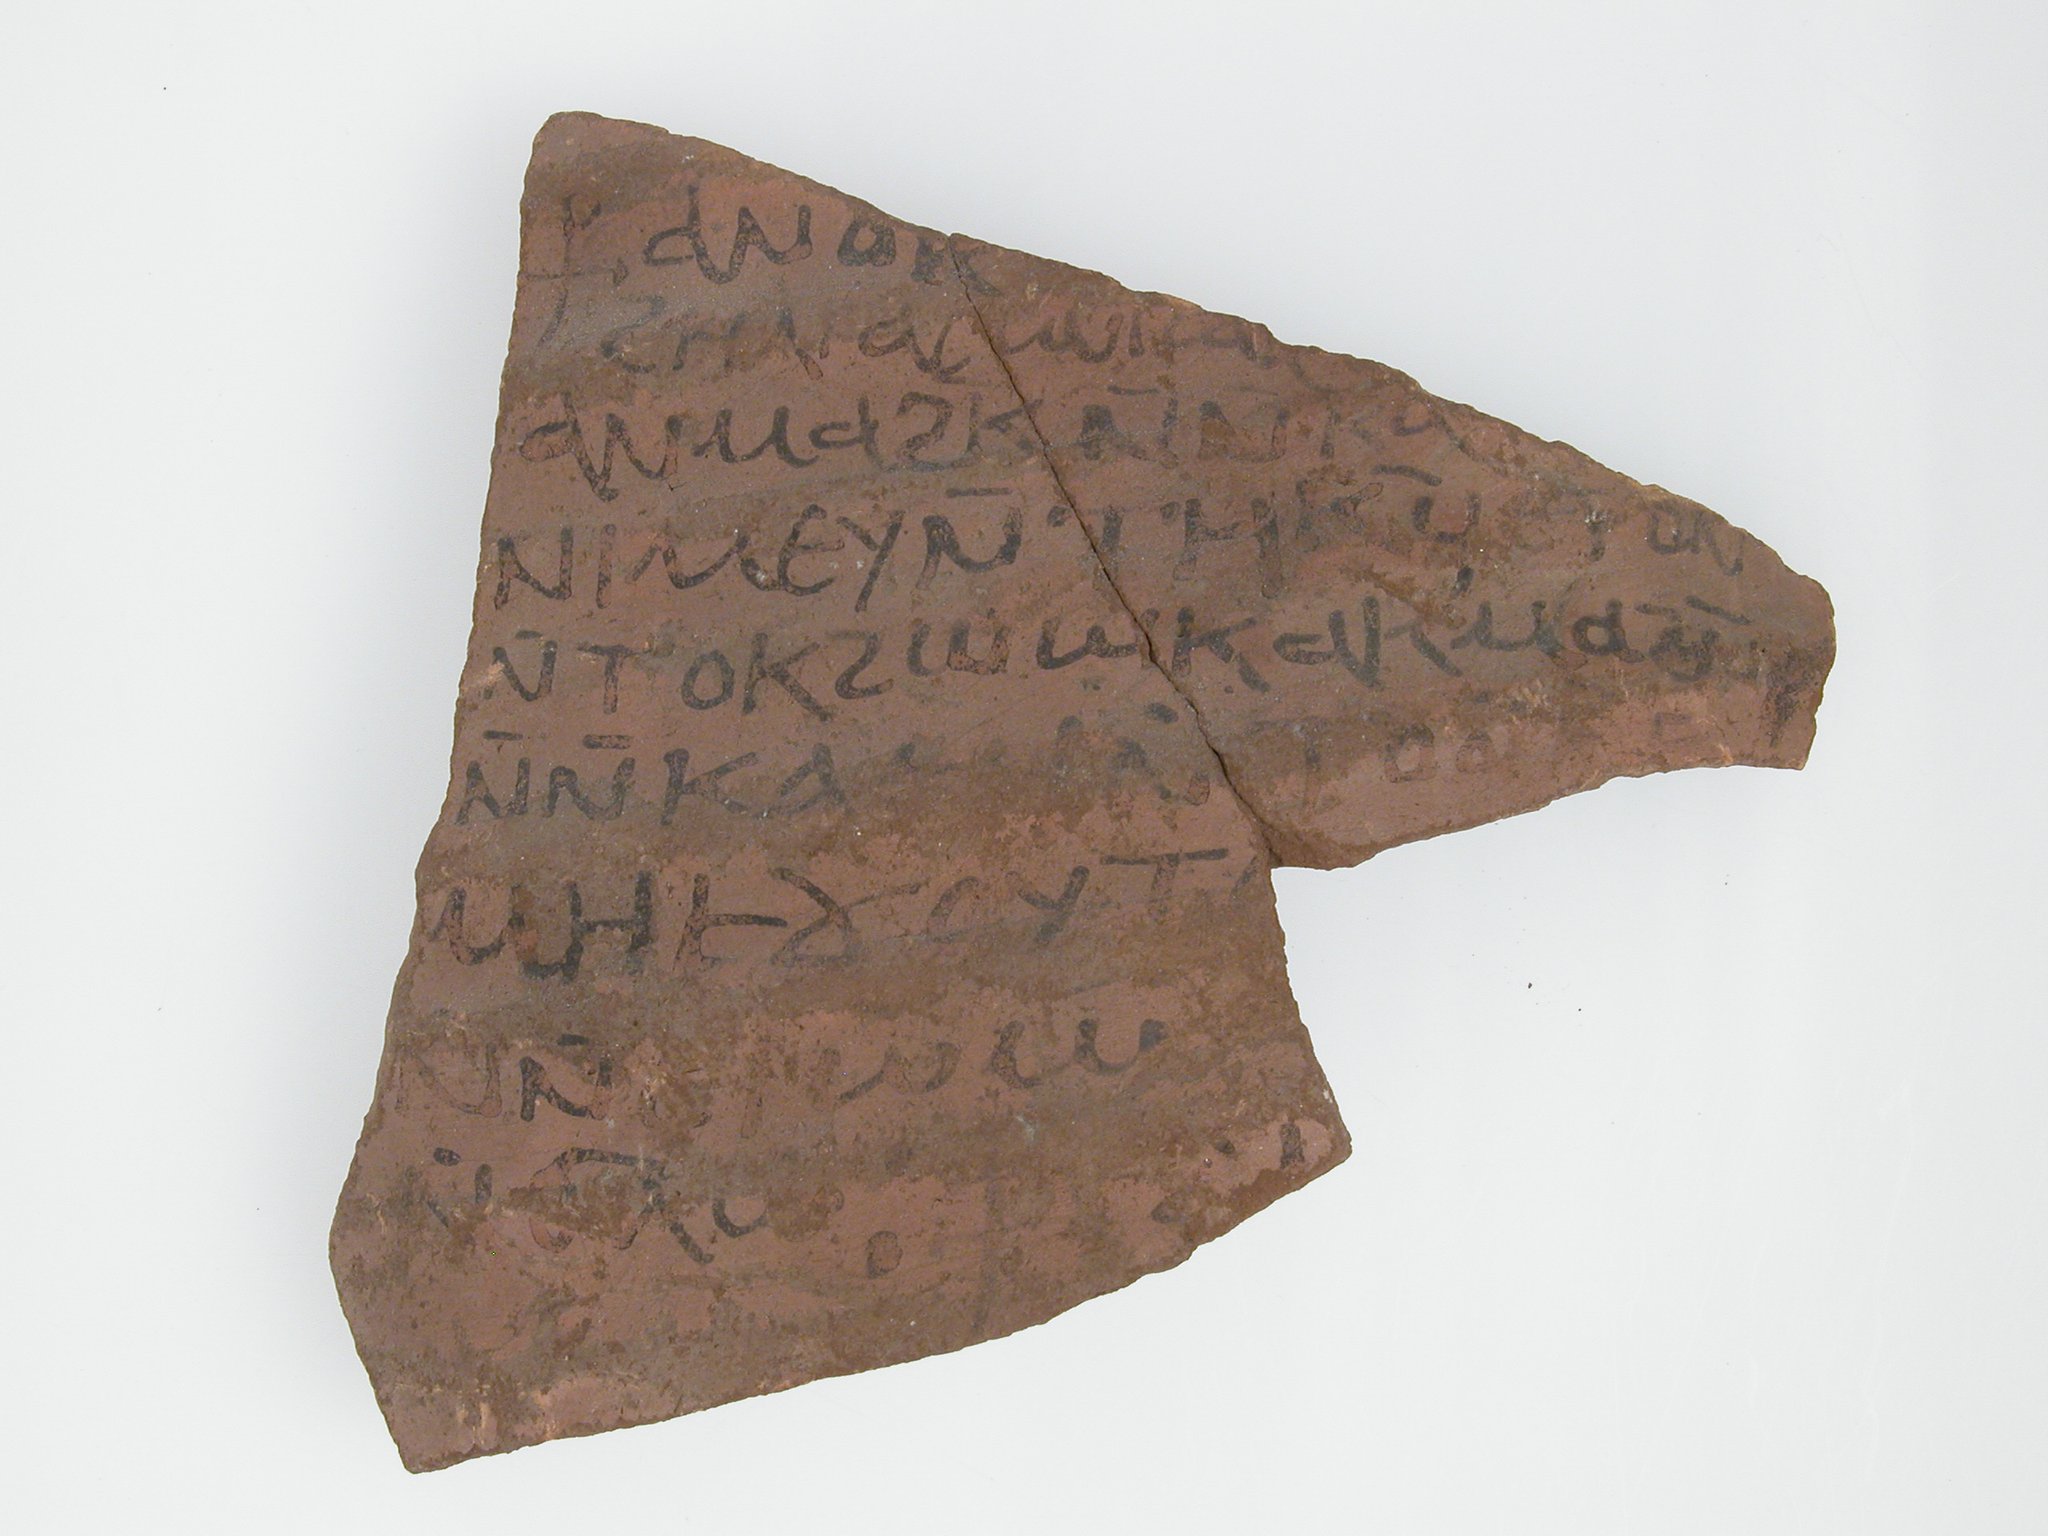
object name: ostrakon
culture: coptic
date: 601-700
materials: ink, pottery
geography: egypt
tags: documents